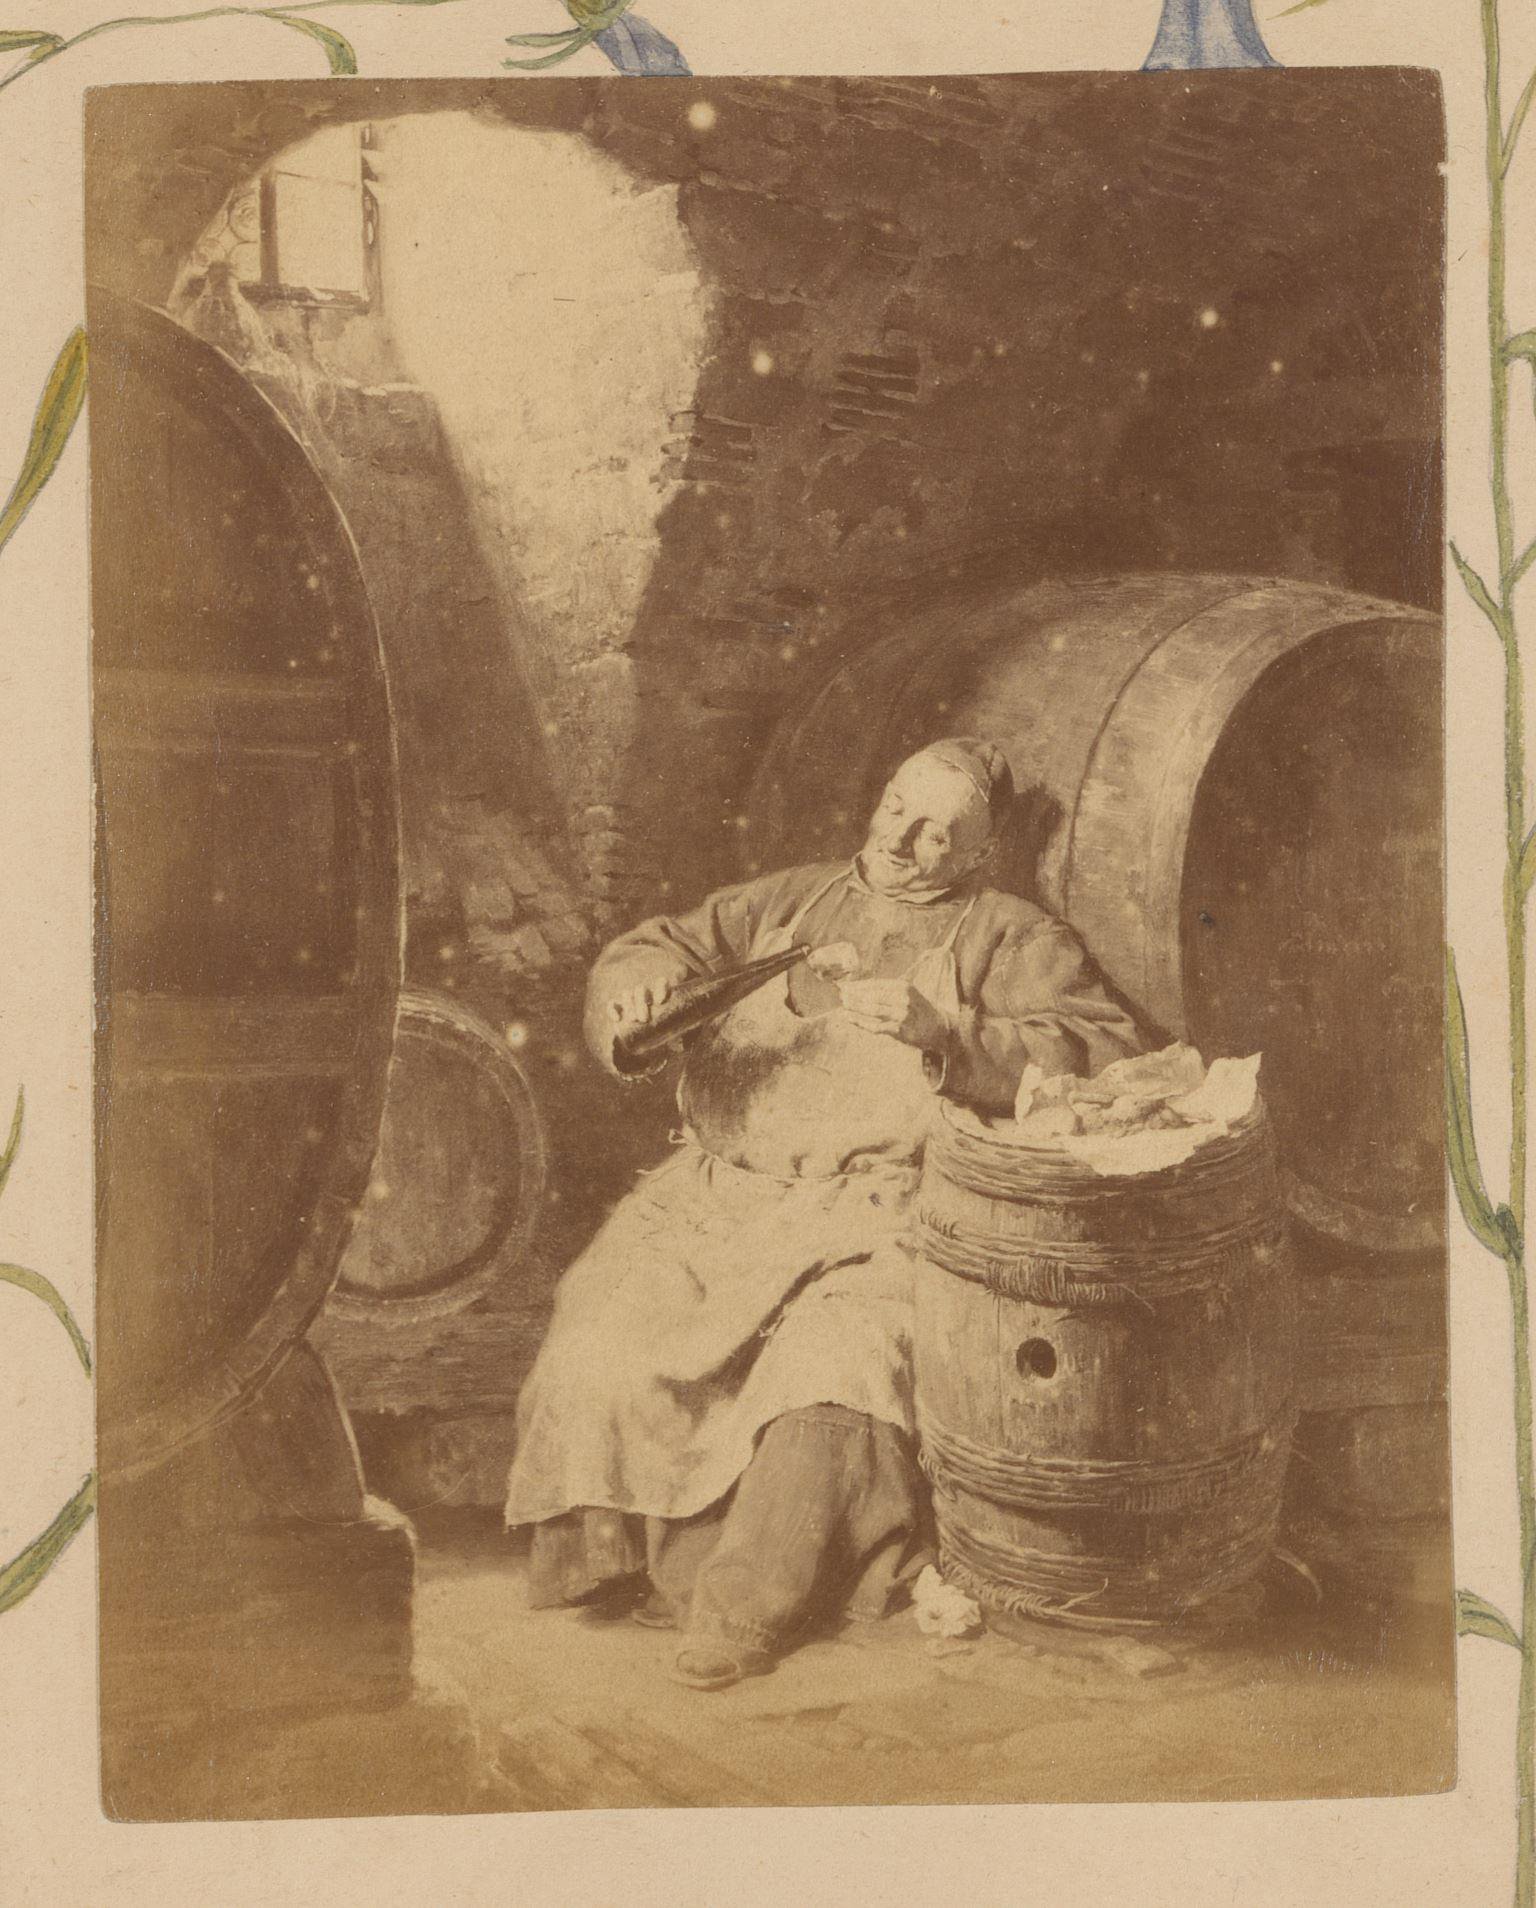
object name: photograph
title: Fotoreproductie van een schilderij met een monnik die wijn drinkt bij een wijnvat naar Eduard Grützner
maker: Anonymous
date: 1875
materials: paper, photographic support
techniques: albumen print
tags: wine-vault, 'cave', monk(s), friar(s)